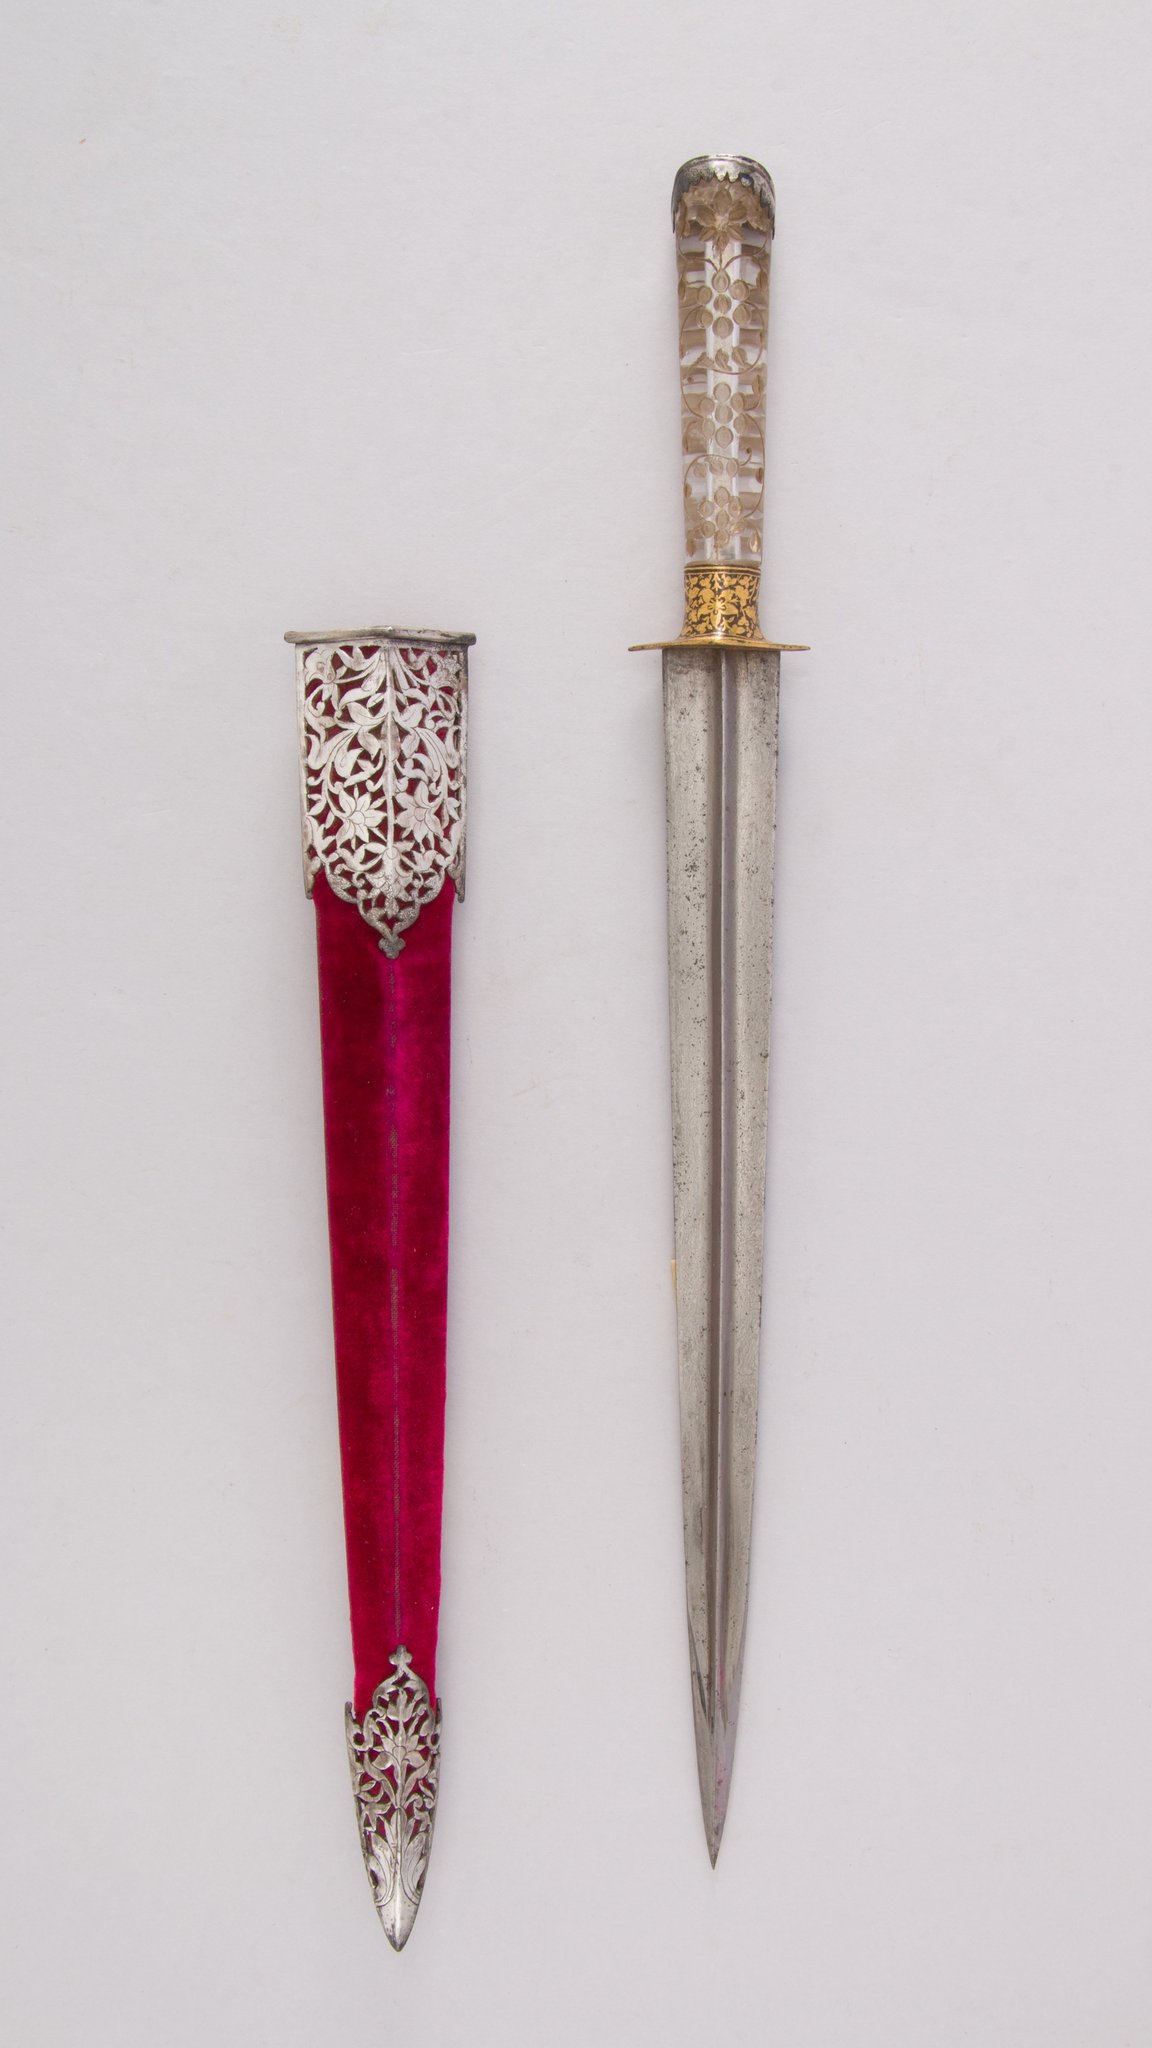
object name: dagger with sheath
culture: indian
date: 1701-1900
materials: gold, quartz, silver, steel, velvet, wood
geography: india